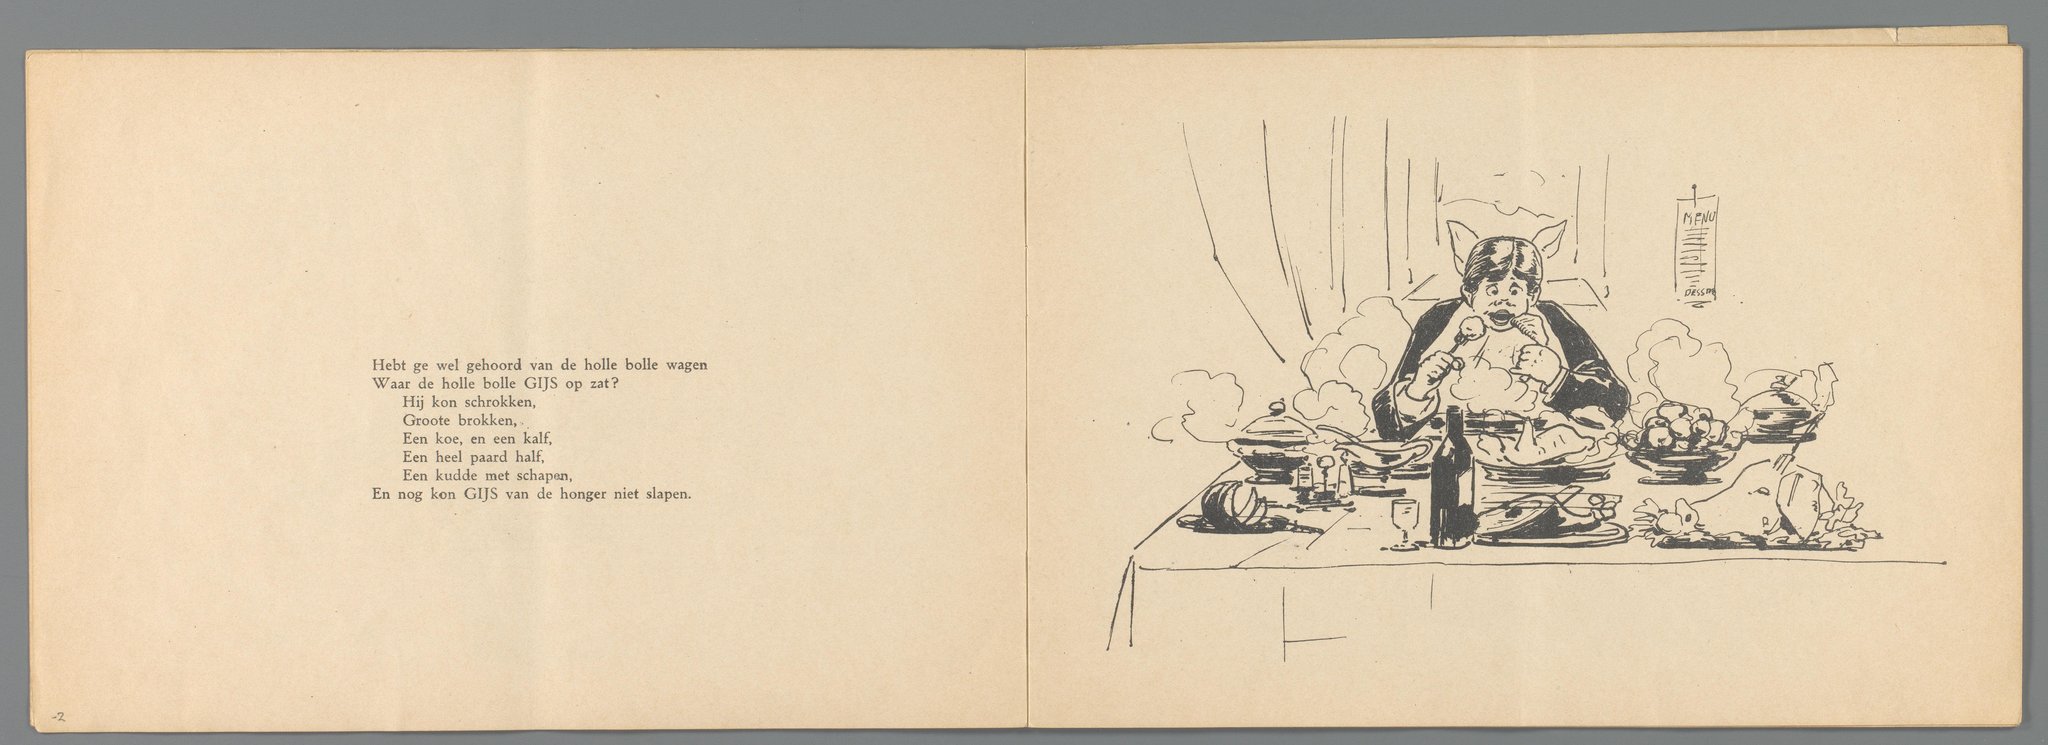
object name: print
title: Jakob Gijsbert de Hoop Scheffer schrokkend als Holle Bolle Gijs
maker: Anonymous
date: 1910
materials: paper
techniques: lithograph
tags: evening meal, dinner, supper, eating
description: Bij gebrek aan gegevens over de vervaardiger is voor de bepaling van de rechten van dit object gebruik gemaakt van de vervaardigingsdatum.